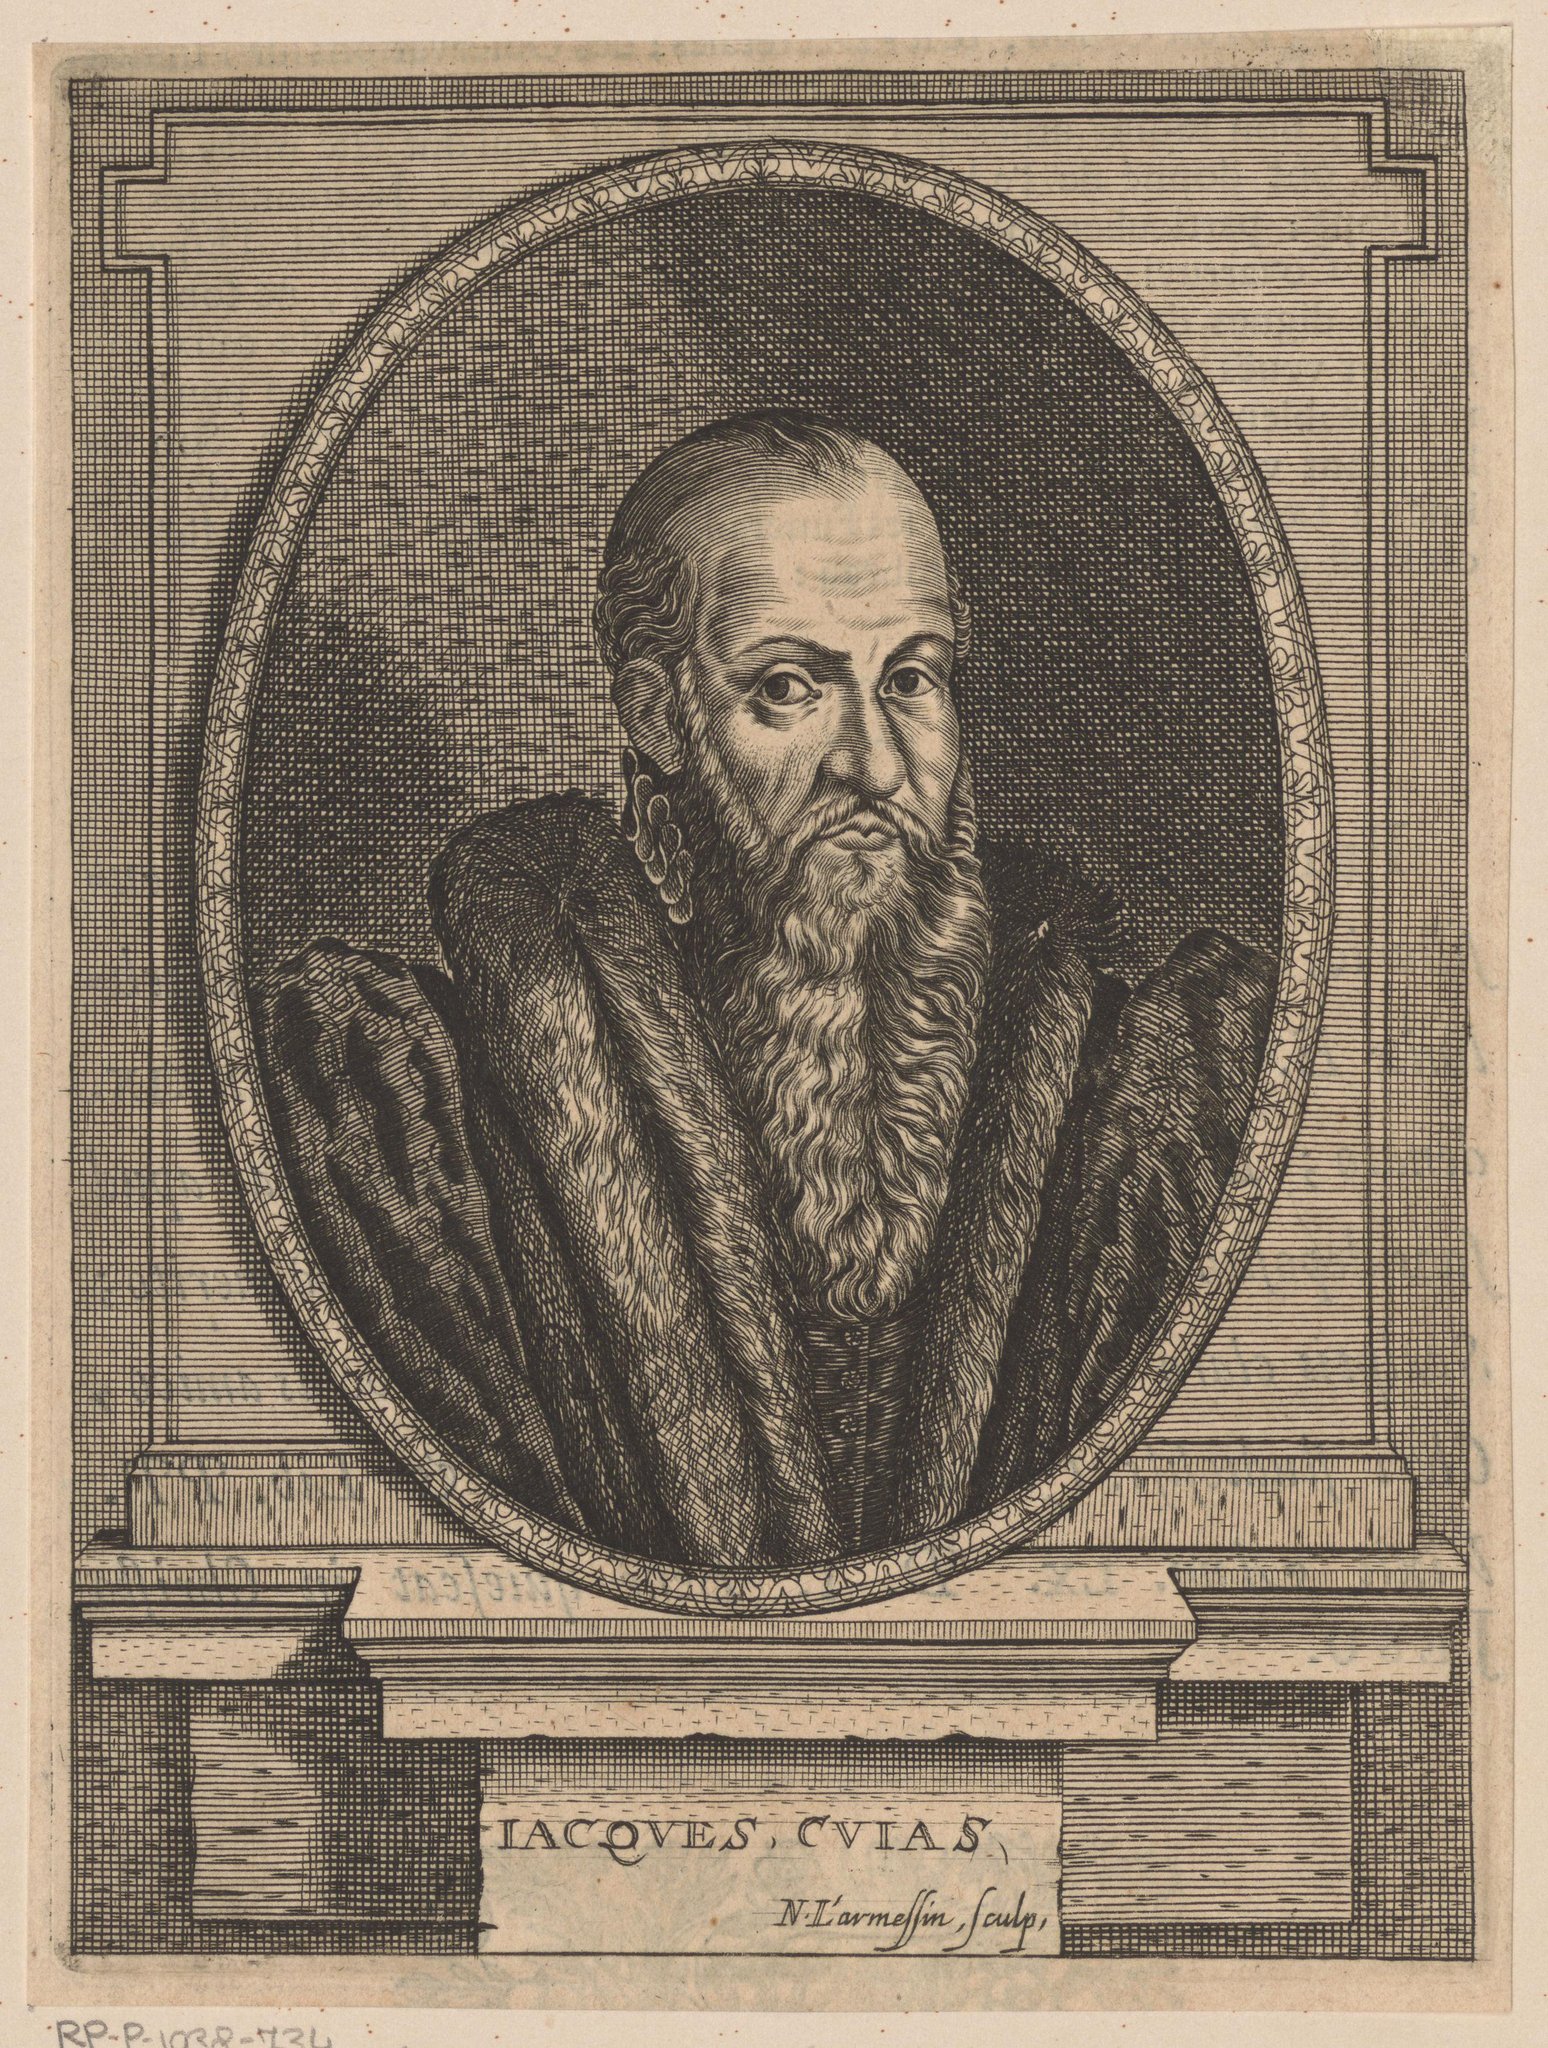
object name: print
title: Portret van Jacques Cujas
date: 1682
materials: paper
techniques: engraving, letterpress printing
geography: amsterdam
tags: historical persons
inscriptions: collector's mark: Lugt 2228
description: Prent uit: Bullart, Isaac. Académie des sciences et des arts. Amsterdam: Daniel Elzevier, 1682.